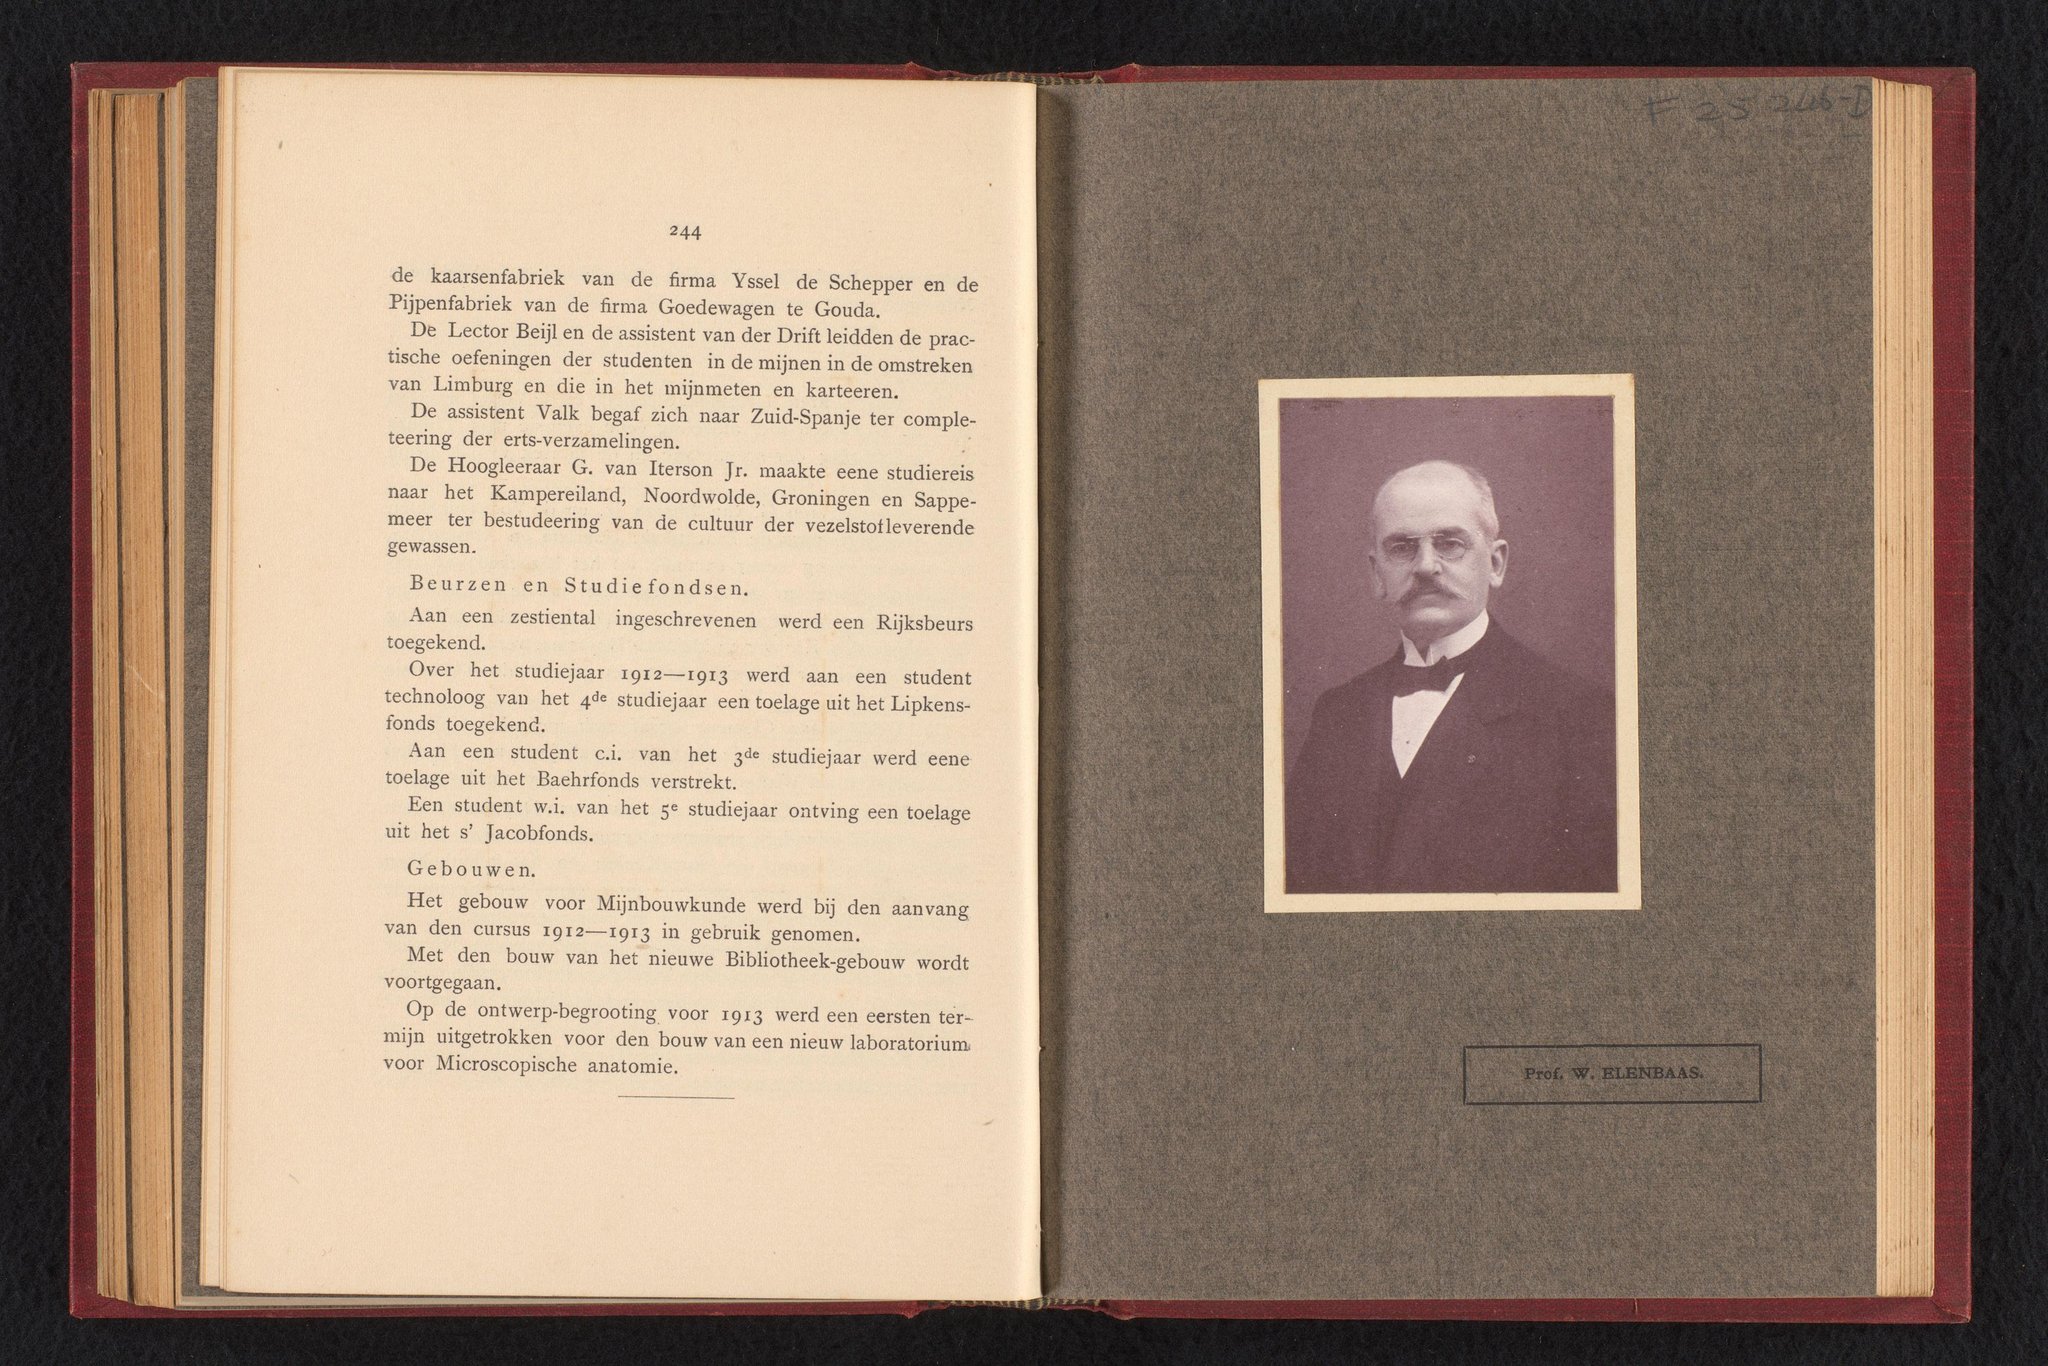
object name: photomechanical print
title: Portret van Willem Elenbaas, hoogleraar waterbouwkunde aan de Polytechnische School Delft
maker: Anonymous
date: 1911-1912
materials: paper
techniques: autotype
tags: the hague, engineer, historical persons, professor